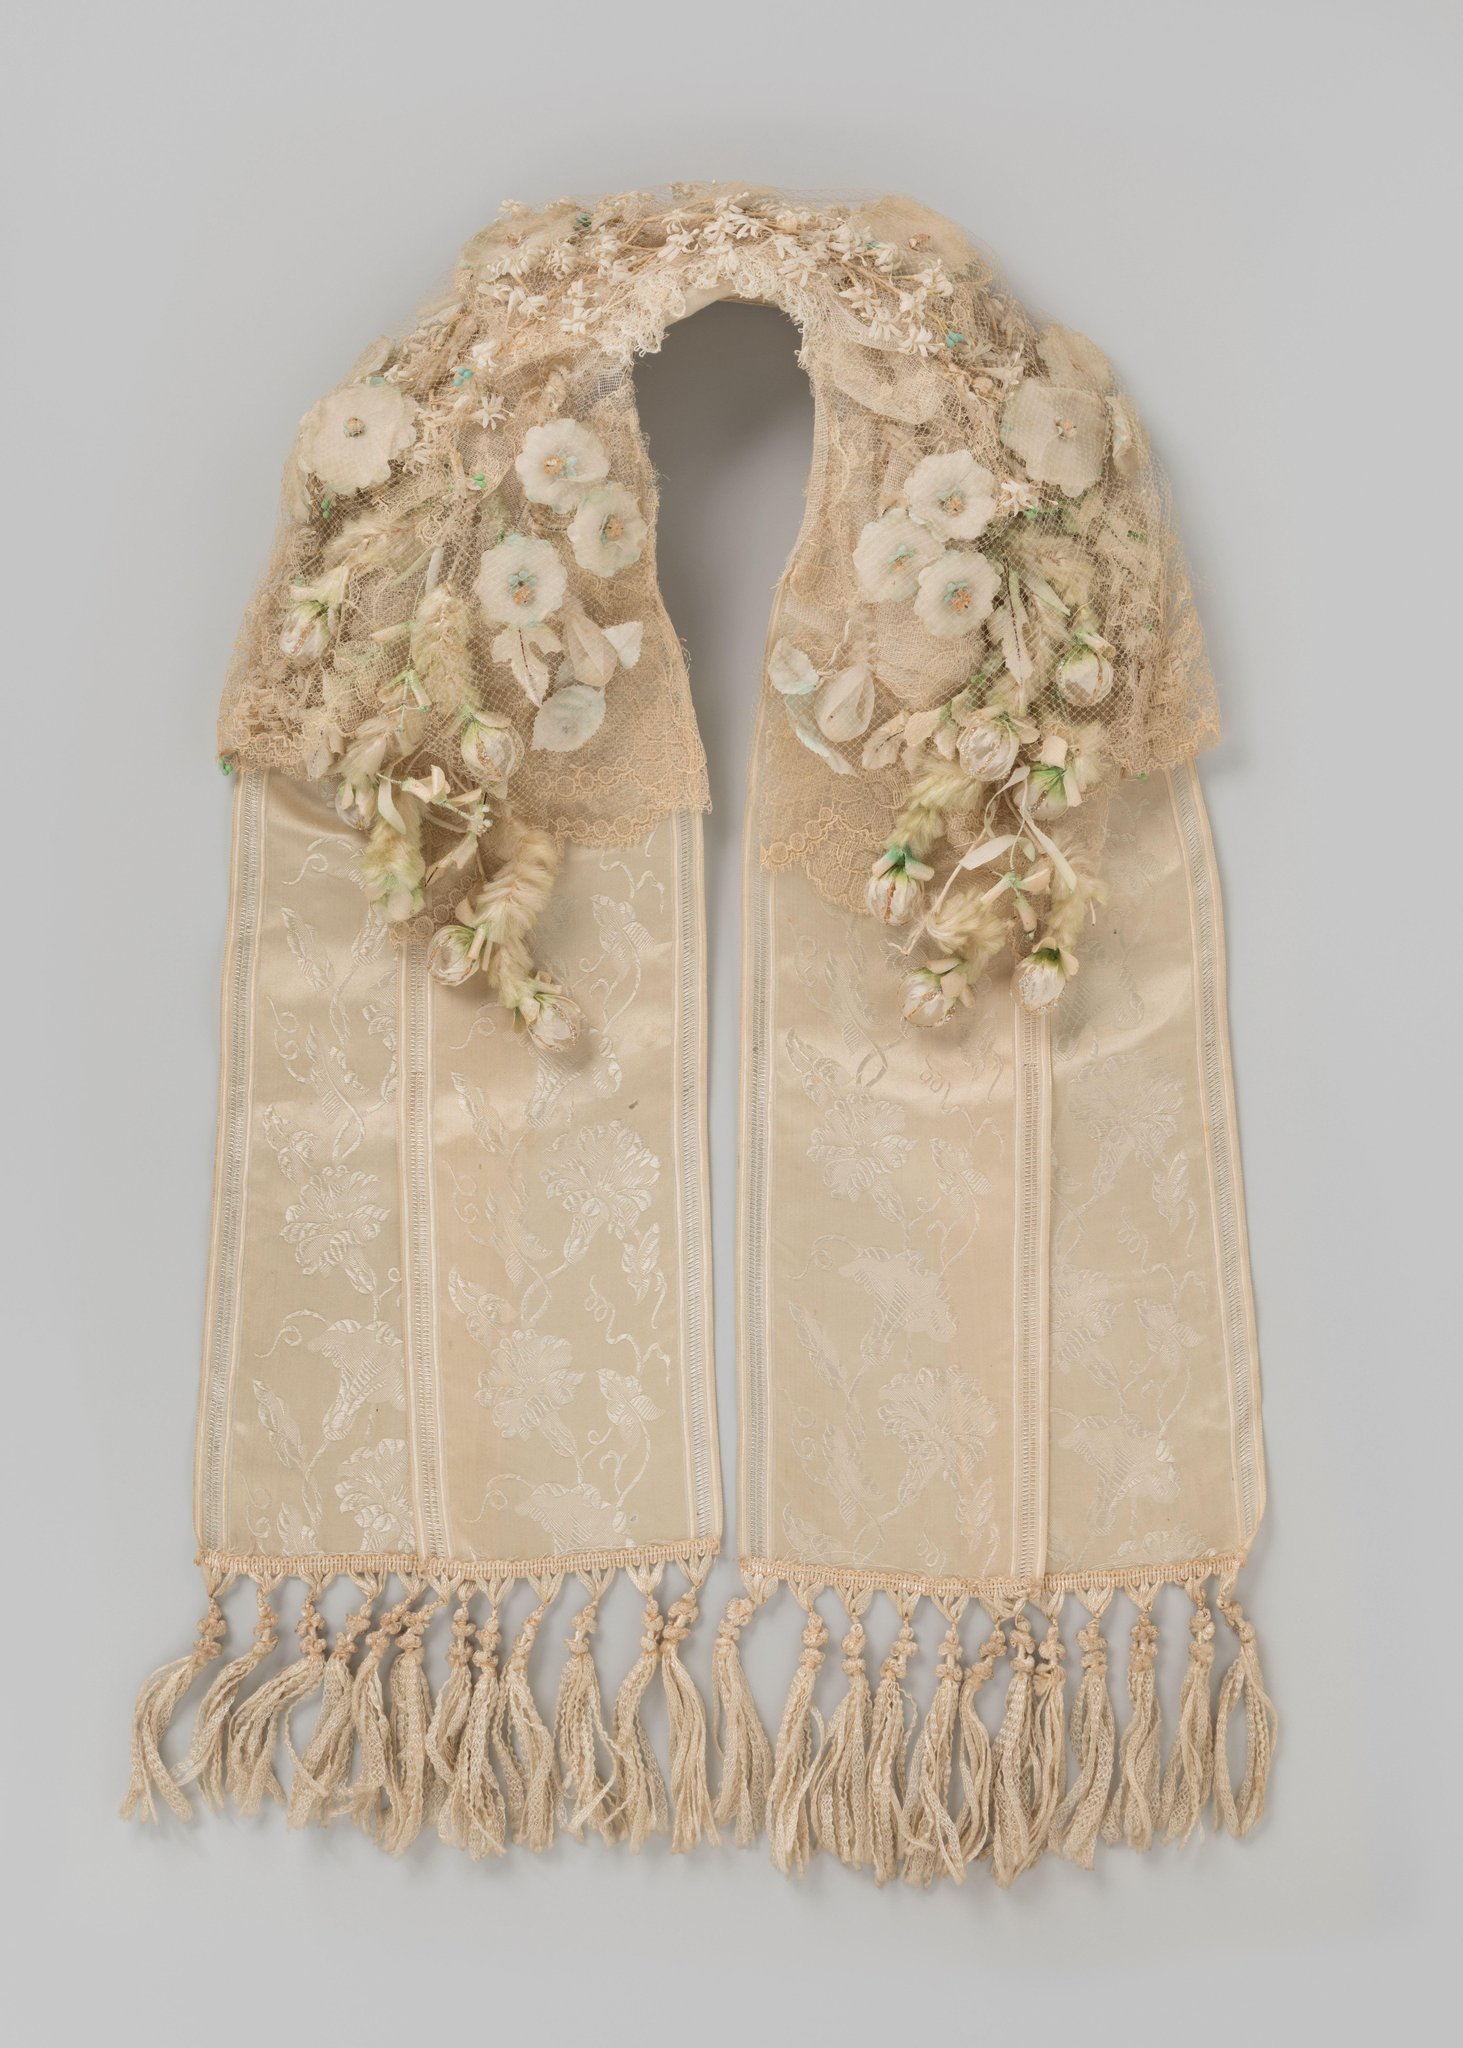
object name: womenswear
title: Poffermuts van witte tule versierd met kleine witte katoenen bloemen, machinale kant en lint van crèmewit zijden damast met patroon van winde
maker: Anonymous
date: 1925-1930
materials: cotton, metal thread, silk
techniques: weave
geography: brabant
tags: fruits: gooseberry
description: Poffermuts, Brabantse poffer, van witte tule versierd met kleine witte katoenen bloemen, kant en lint van crèmewit zijden damast. Model: op een brede, gebogen band van sparterie, de zogenaamde toer, die voor het op het hoofd geplaatst wordt, zijn de bloemetjes luchtig opgetast en over de gehele breedte bedekt met een strook machinaal kant dat aan de zijkanten is vastgezet. Aan de uiteinden hangen takken met satijnen kruisbessen af over de brede zijdendamasten linten, die aan de uiteinden zijn afgezet met witte zijden franje. Versiering: aan de voorkant is tegen de hoge bloementoef een gesteven en geplooide strok kant gezet. De witte bloemen bestaan uit: fijne bloemtrossen, babyroosjes met witte bladeren met kleine groene vlekken, trossen kruisbessen.